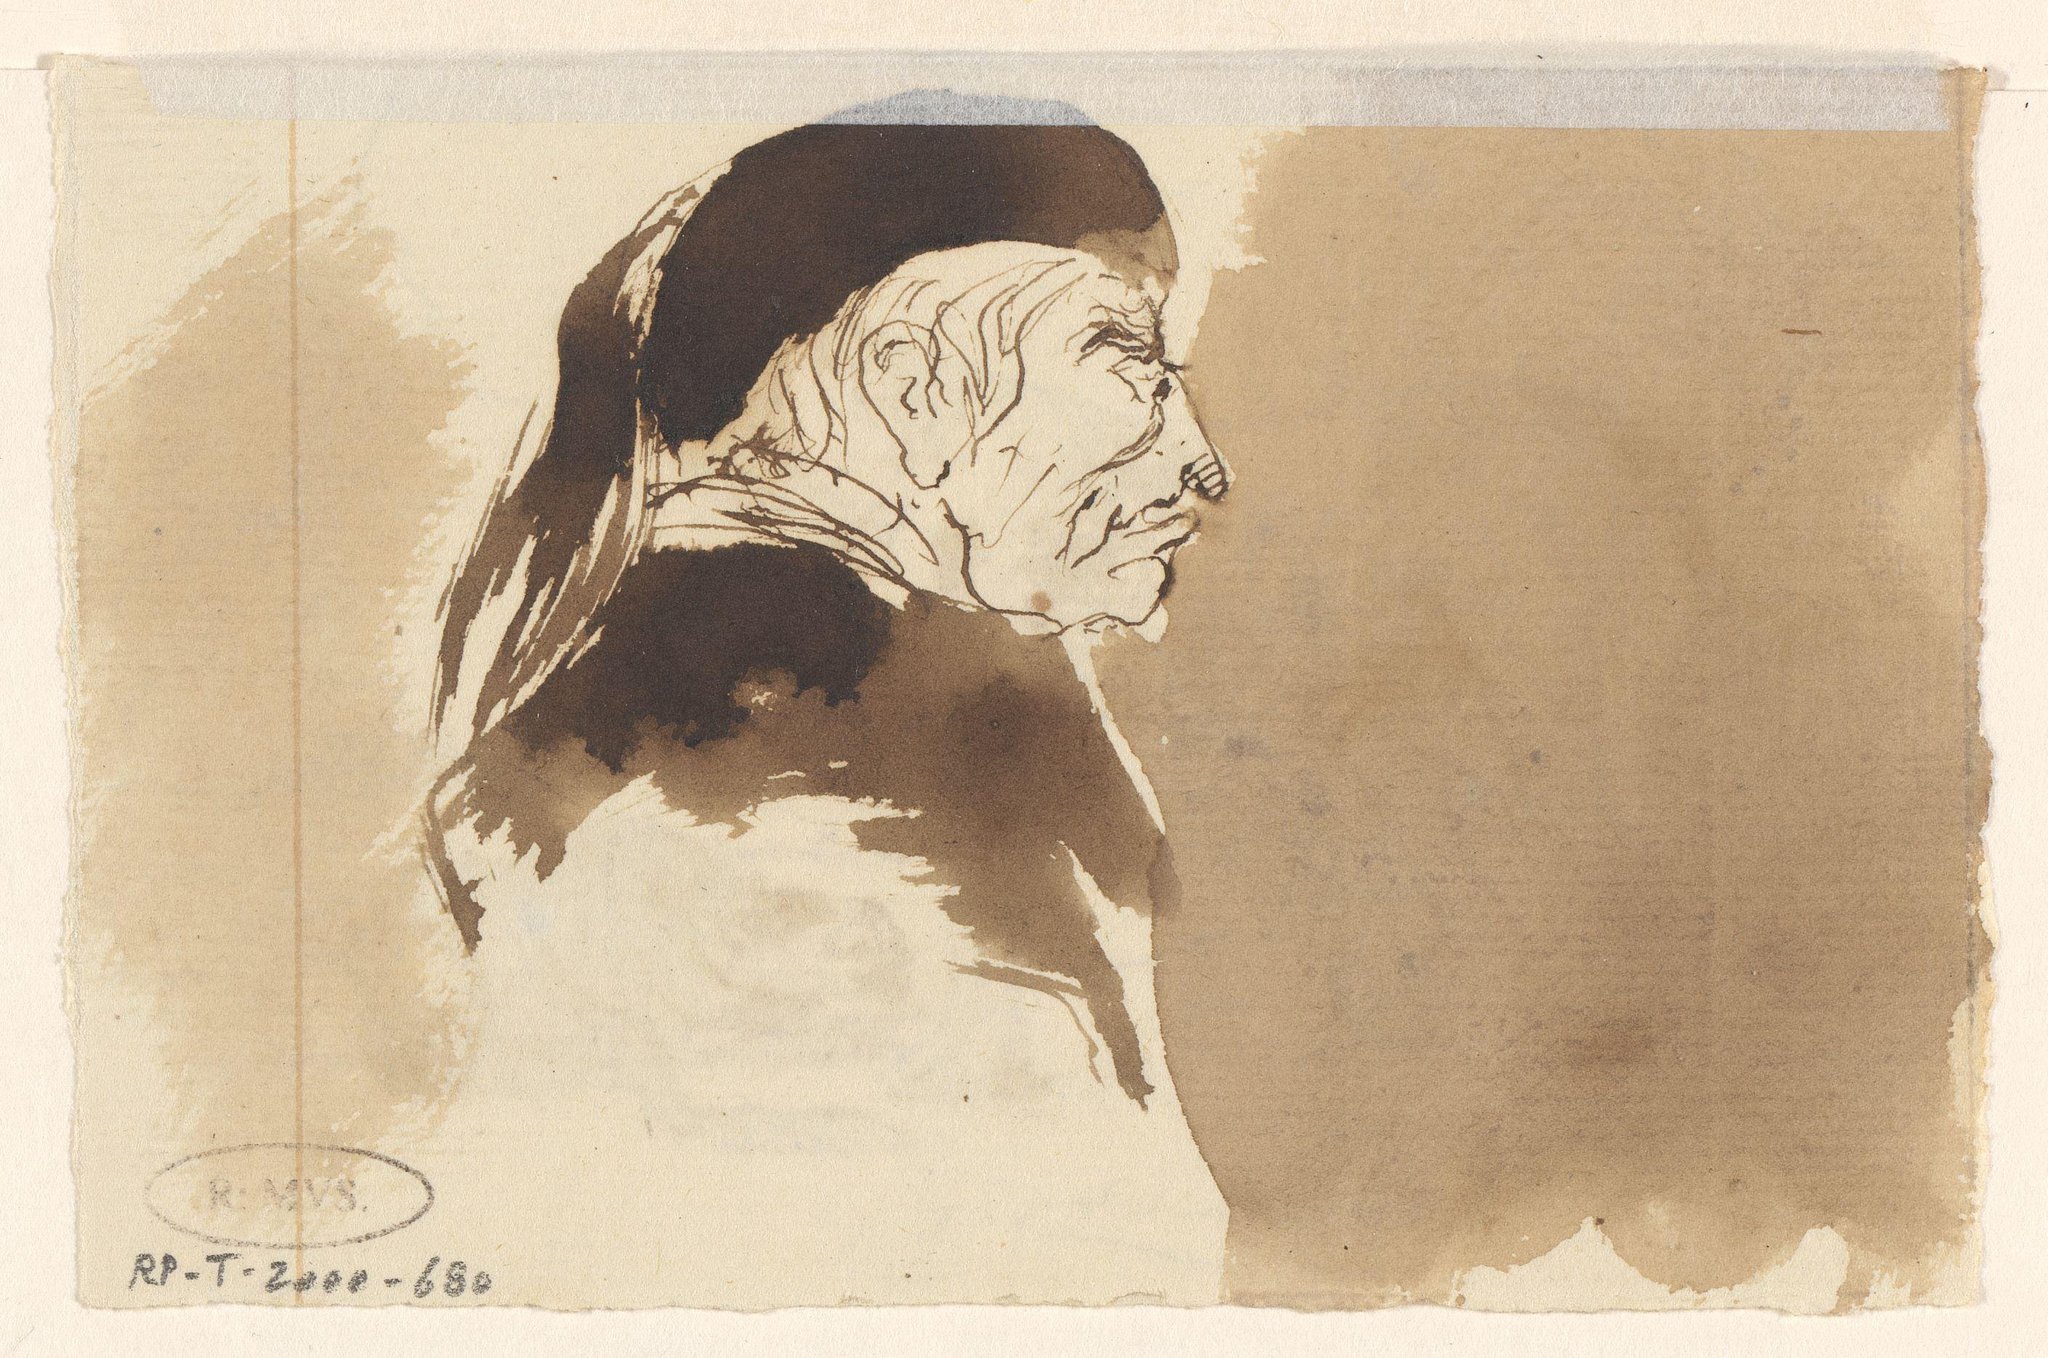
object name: drawing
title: Manskop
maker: johannes tavenraat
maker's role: draughtsman, painter, print maker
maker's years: 1809-1881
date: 1840-1880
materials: ink, paper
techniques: brush, pen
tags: head (human), caricatures (human types)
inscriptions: collector's mark: Lugt 2228, signature: ‘Tavenraat’